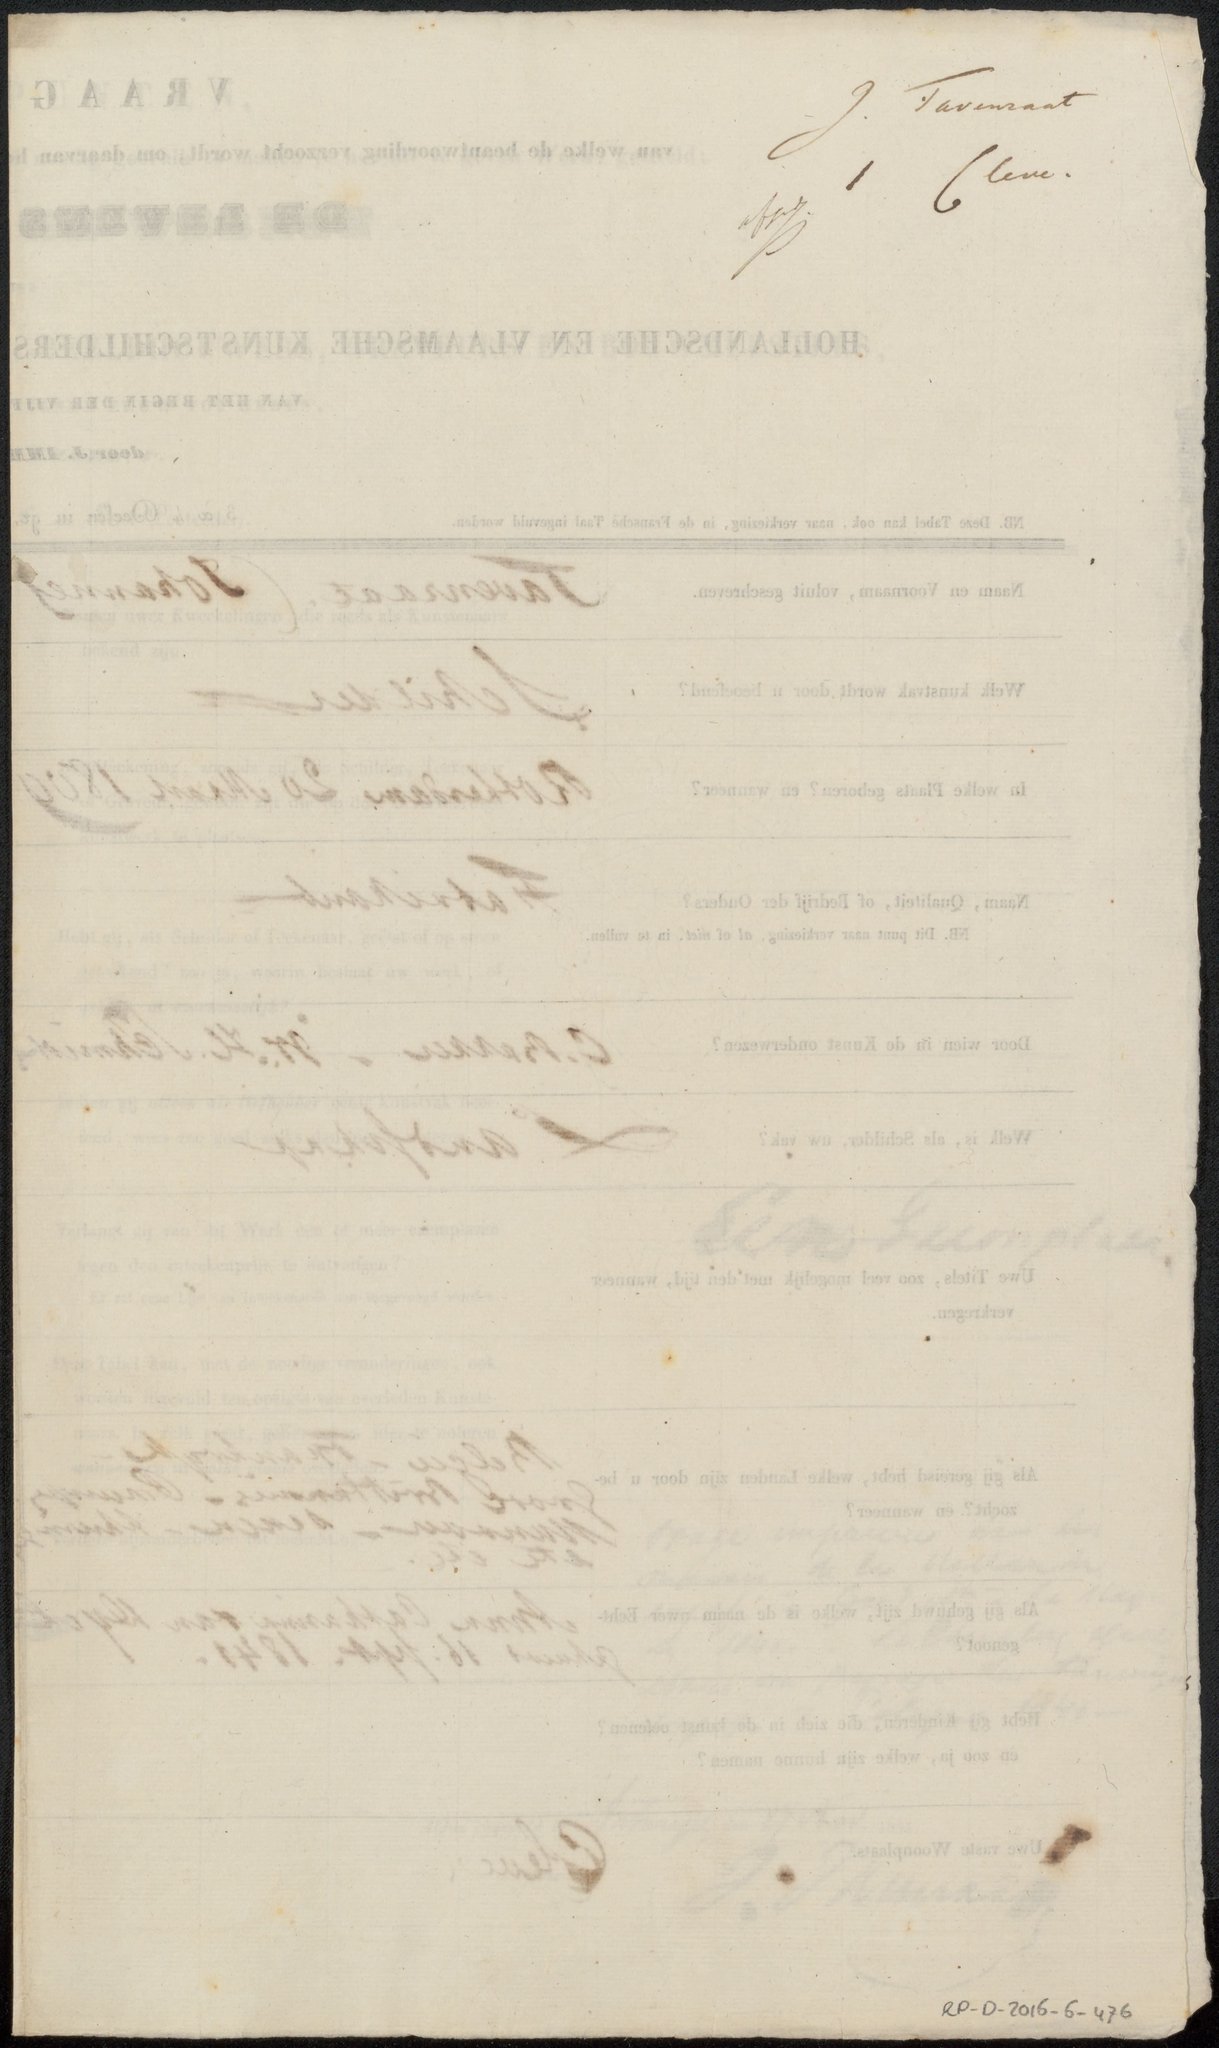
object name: manuscript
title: Enquêteformulier ingevuld door Johannes Tavenraat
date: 1841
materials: ink, paper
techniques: pen, printing, writing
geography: antwerp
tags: rotterdam, painter, print maker, draughtsman, johannes tavenraat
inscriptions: watermark, inscription: ‘Vraagpunten,/ van welke de beantwoording verzocht wordt, om daarvan het noodig gebruik te maken in het uit te geven Werk, getiteld: De levens en werken/ der Hollandsche en Vlaamsche kunstschilders, beeldhouwers,/ graveurs en bouwmeesters, van het begin der vijftiende eeuw tot heden/ door J. Immerzeel, Jr.’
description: Opgenomen in: Immerzeel, J. Jr., De levens en werken der Hollandsche en Vlaamsche kunstschilders, beeldhouwers, graveurs en bouwmeesters, van het begin der vijftiende eeuw tot heden, Amsterdam: J.C. van Kesteren, 1842-1843.